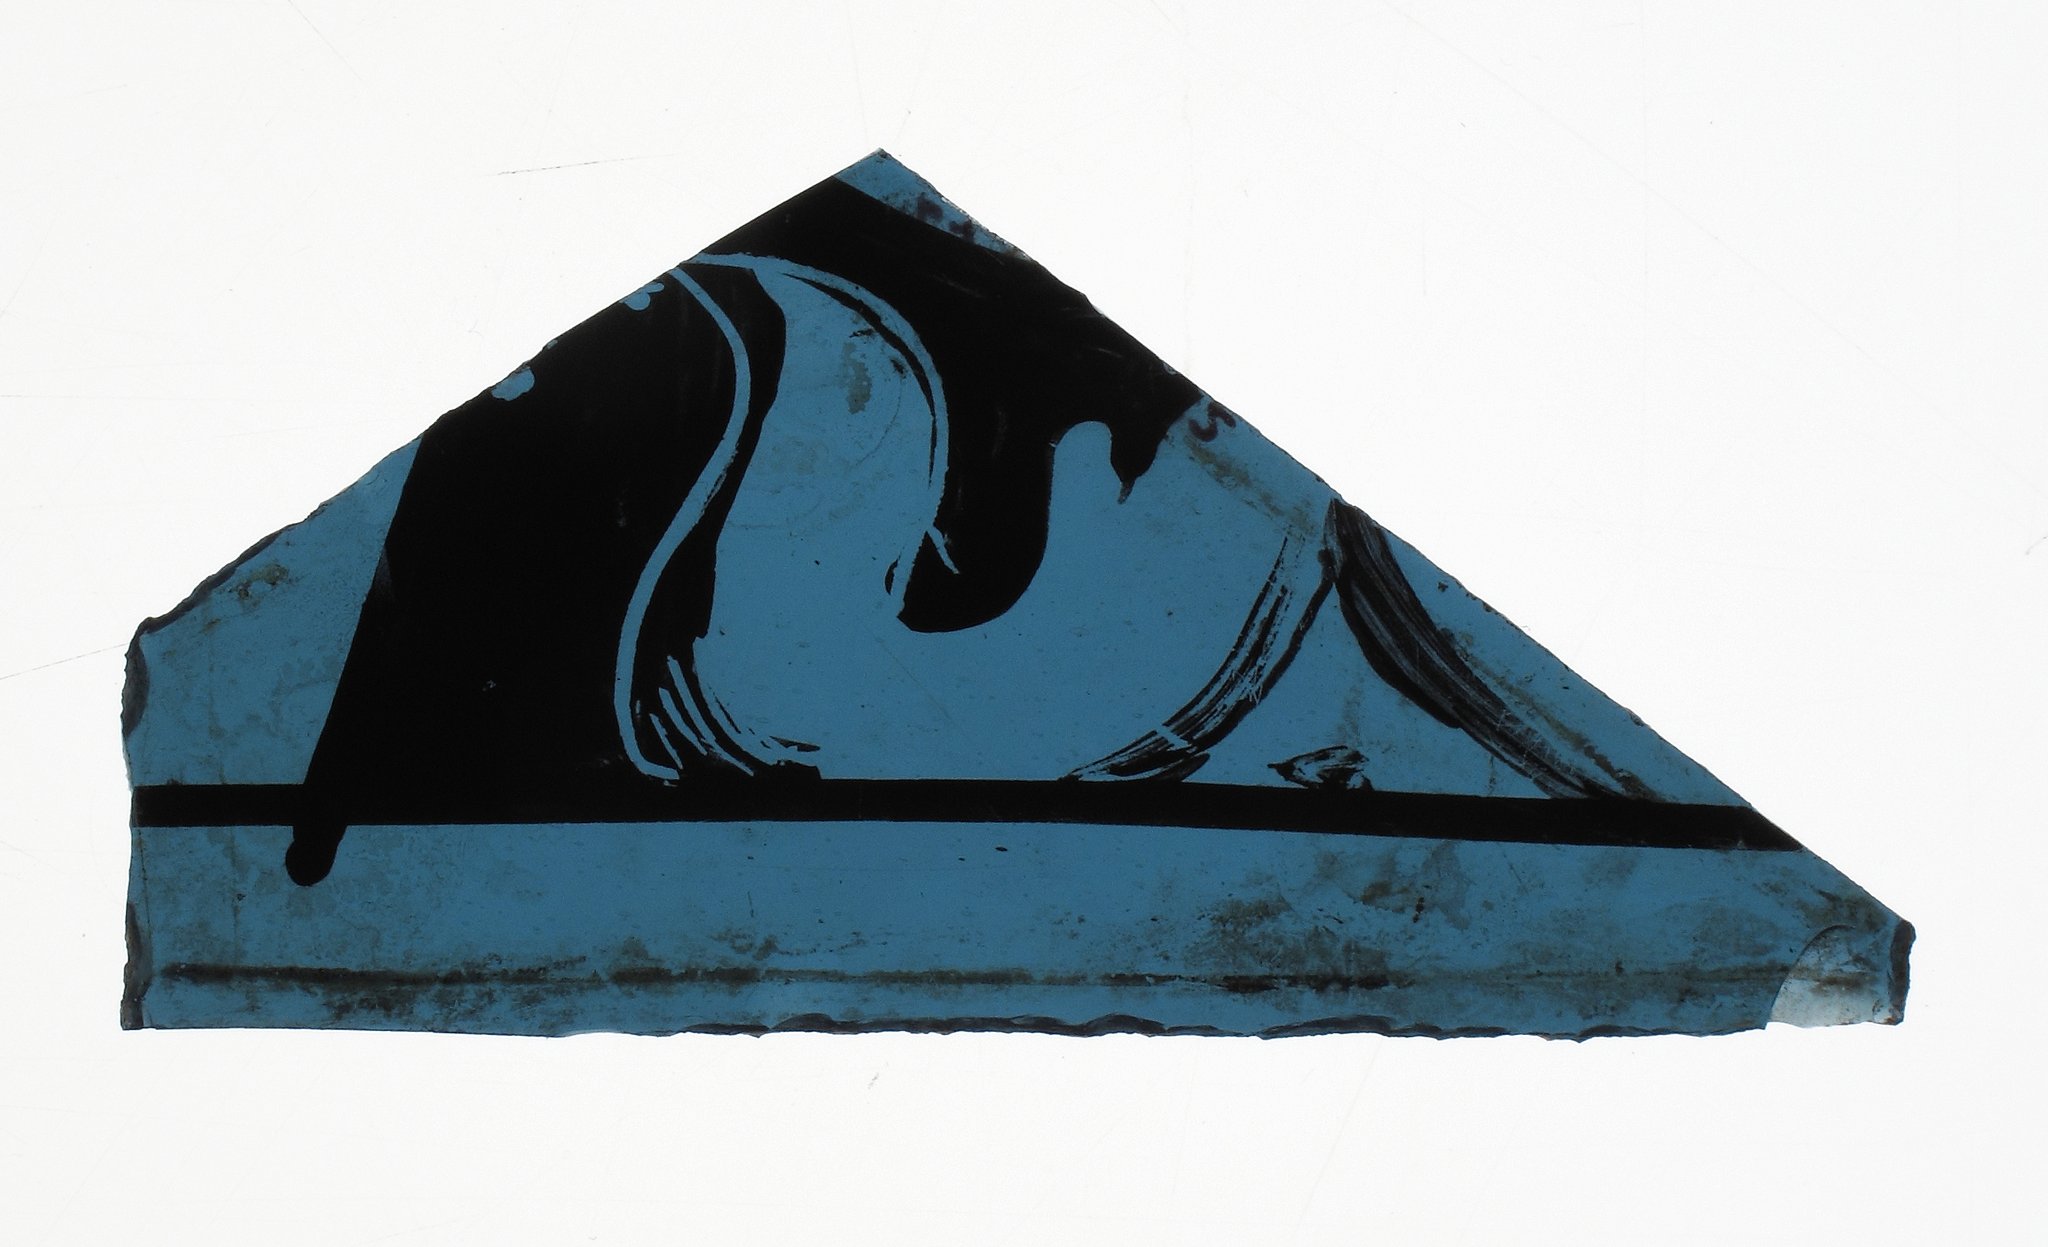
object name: fragment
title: Glass Fragment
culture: french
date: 1201-1300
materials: glass, metal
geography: france